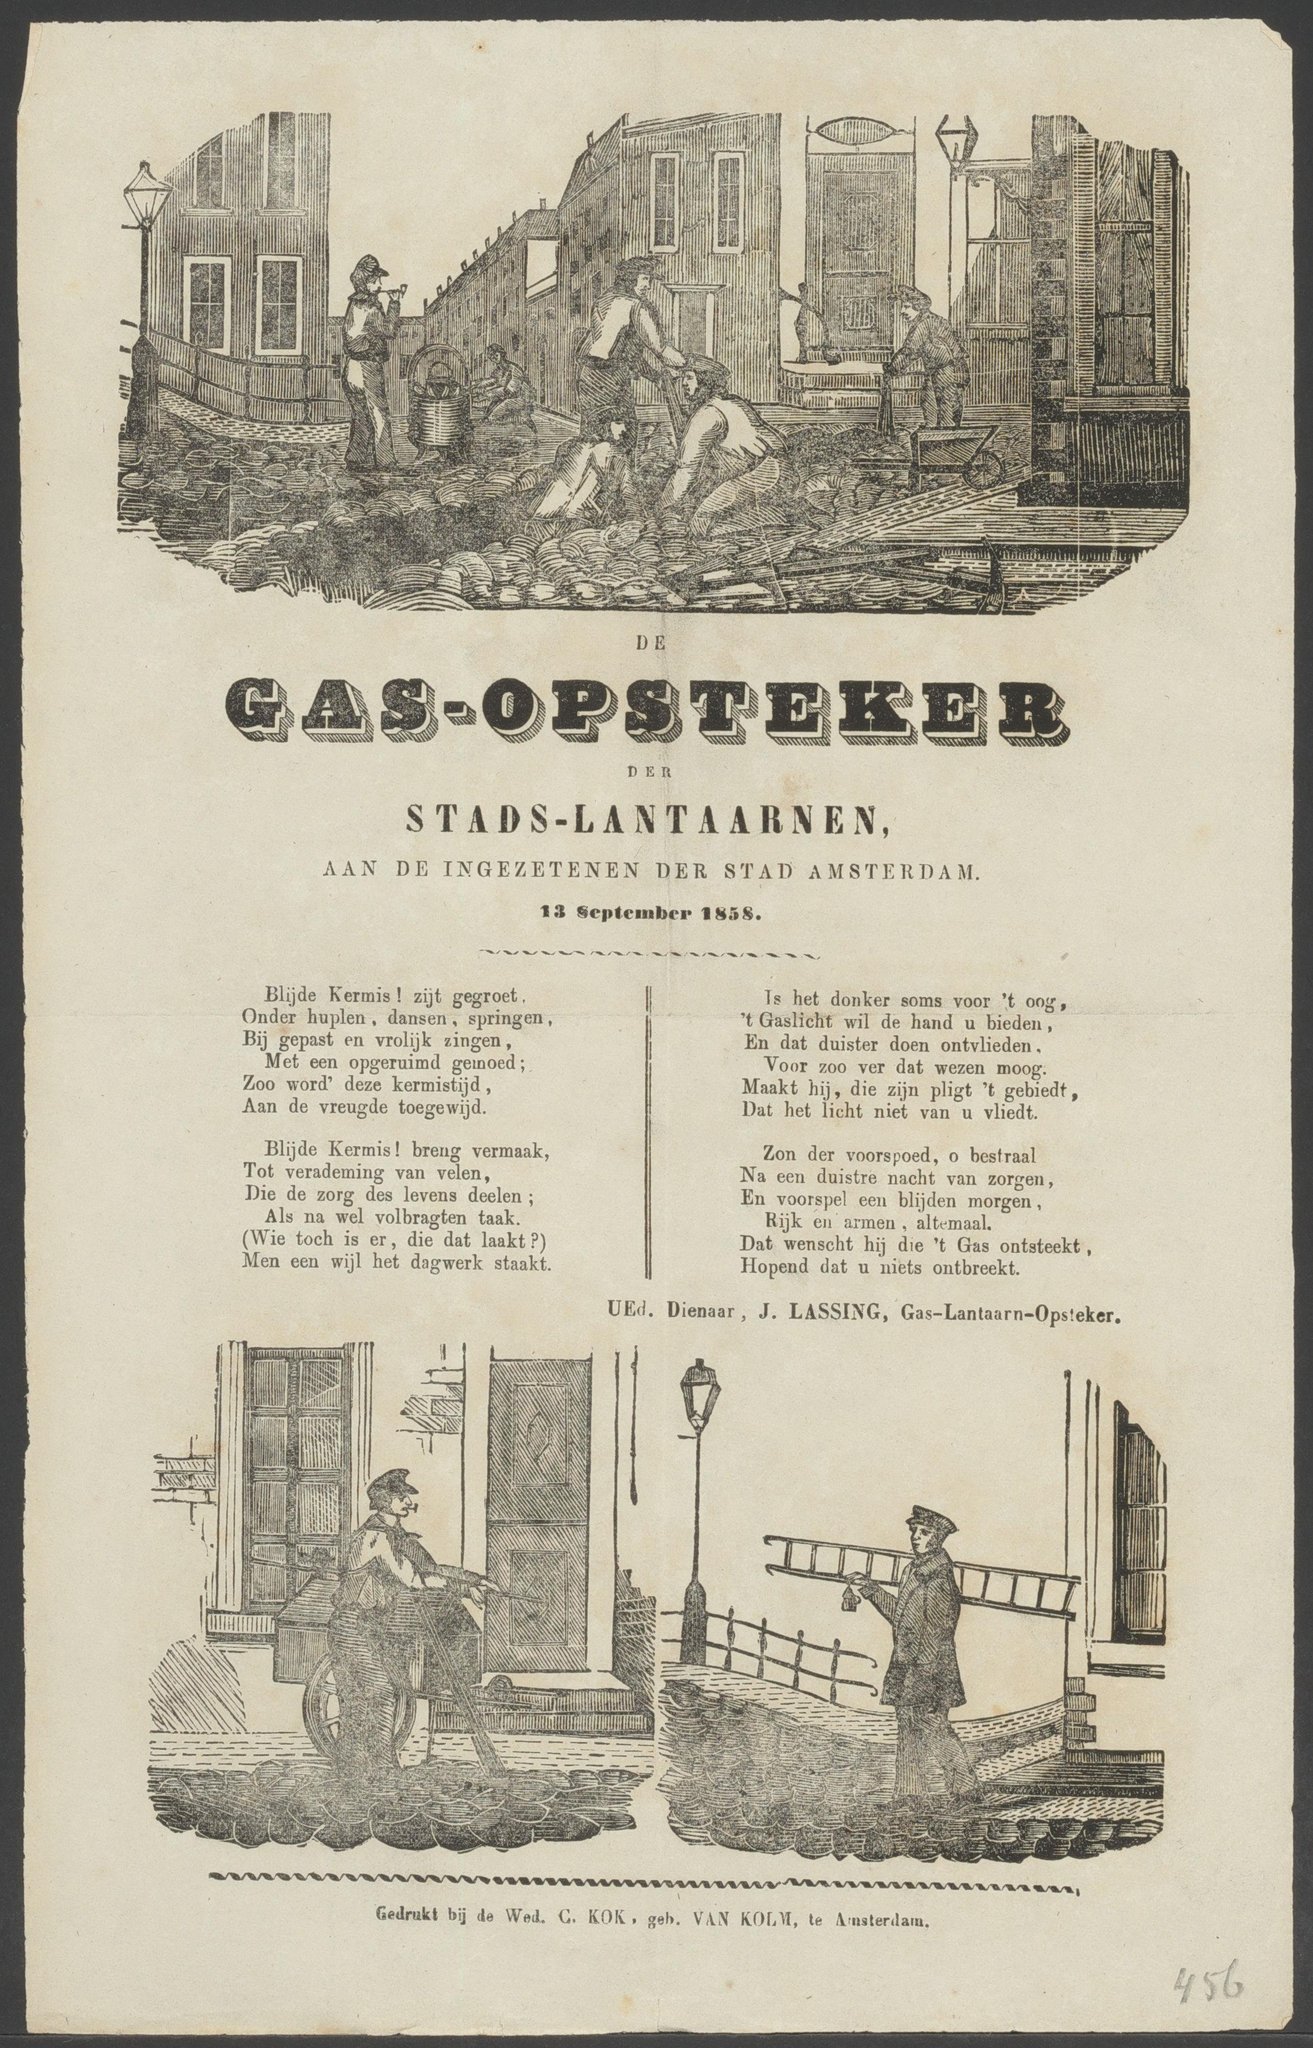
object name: print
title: De Gas-opsteker der Stads-lantaarnen, aan de ingezetenen der stad Amsterdam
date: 1858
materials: paper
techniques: letterpress printing, engraving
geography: amsterdam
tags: gas-lamp, gas supply, digging (industrial process), street lighting, amsterdam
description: Kermiswens van de Amsterdamse gaslantaarnopstekers voor het jaar 1858. Centraal een vers in twee kolommen. Bovenaan een straat in Amsterdam opgebroken voor de aanleg van de gasleiding. Onderaan twee gasfitters. Van de gaslantaarnopsteker: J. Lassing. Onderwerpsrubrieken binnen de Atlas Zeden en Gewoonten: Zeden en gewoonten in engeren zin, Volksleven, Volksbladen, Nieuwjaars- en Kerstwenschen, Amsterdam.